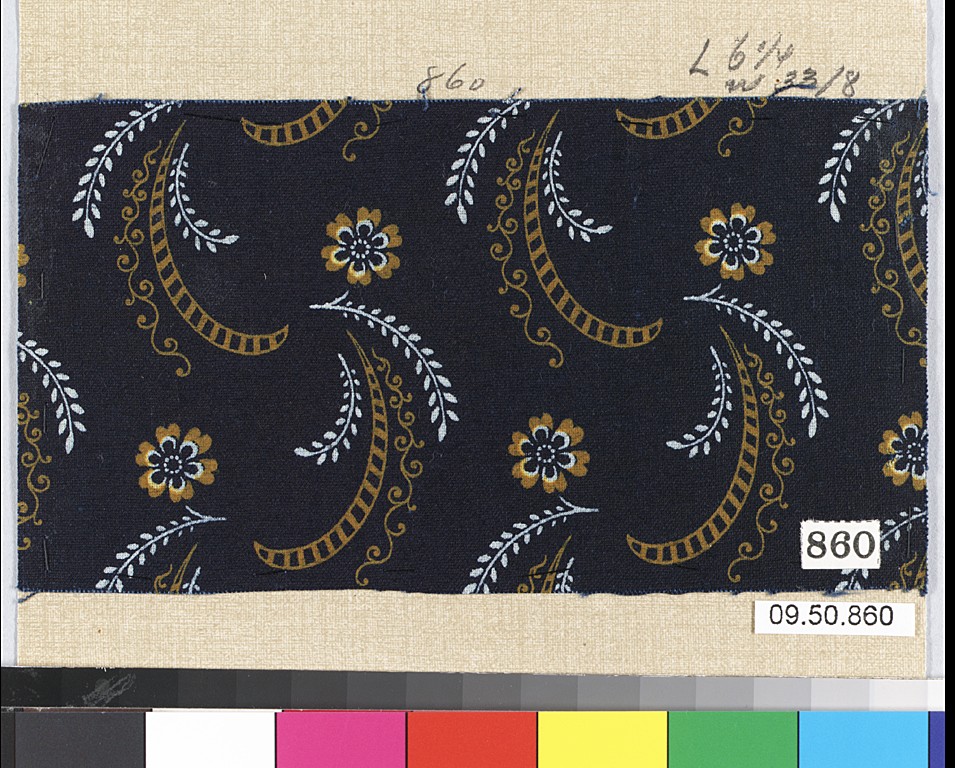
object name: piece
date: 1801-1900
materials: cotton